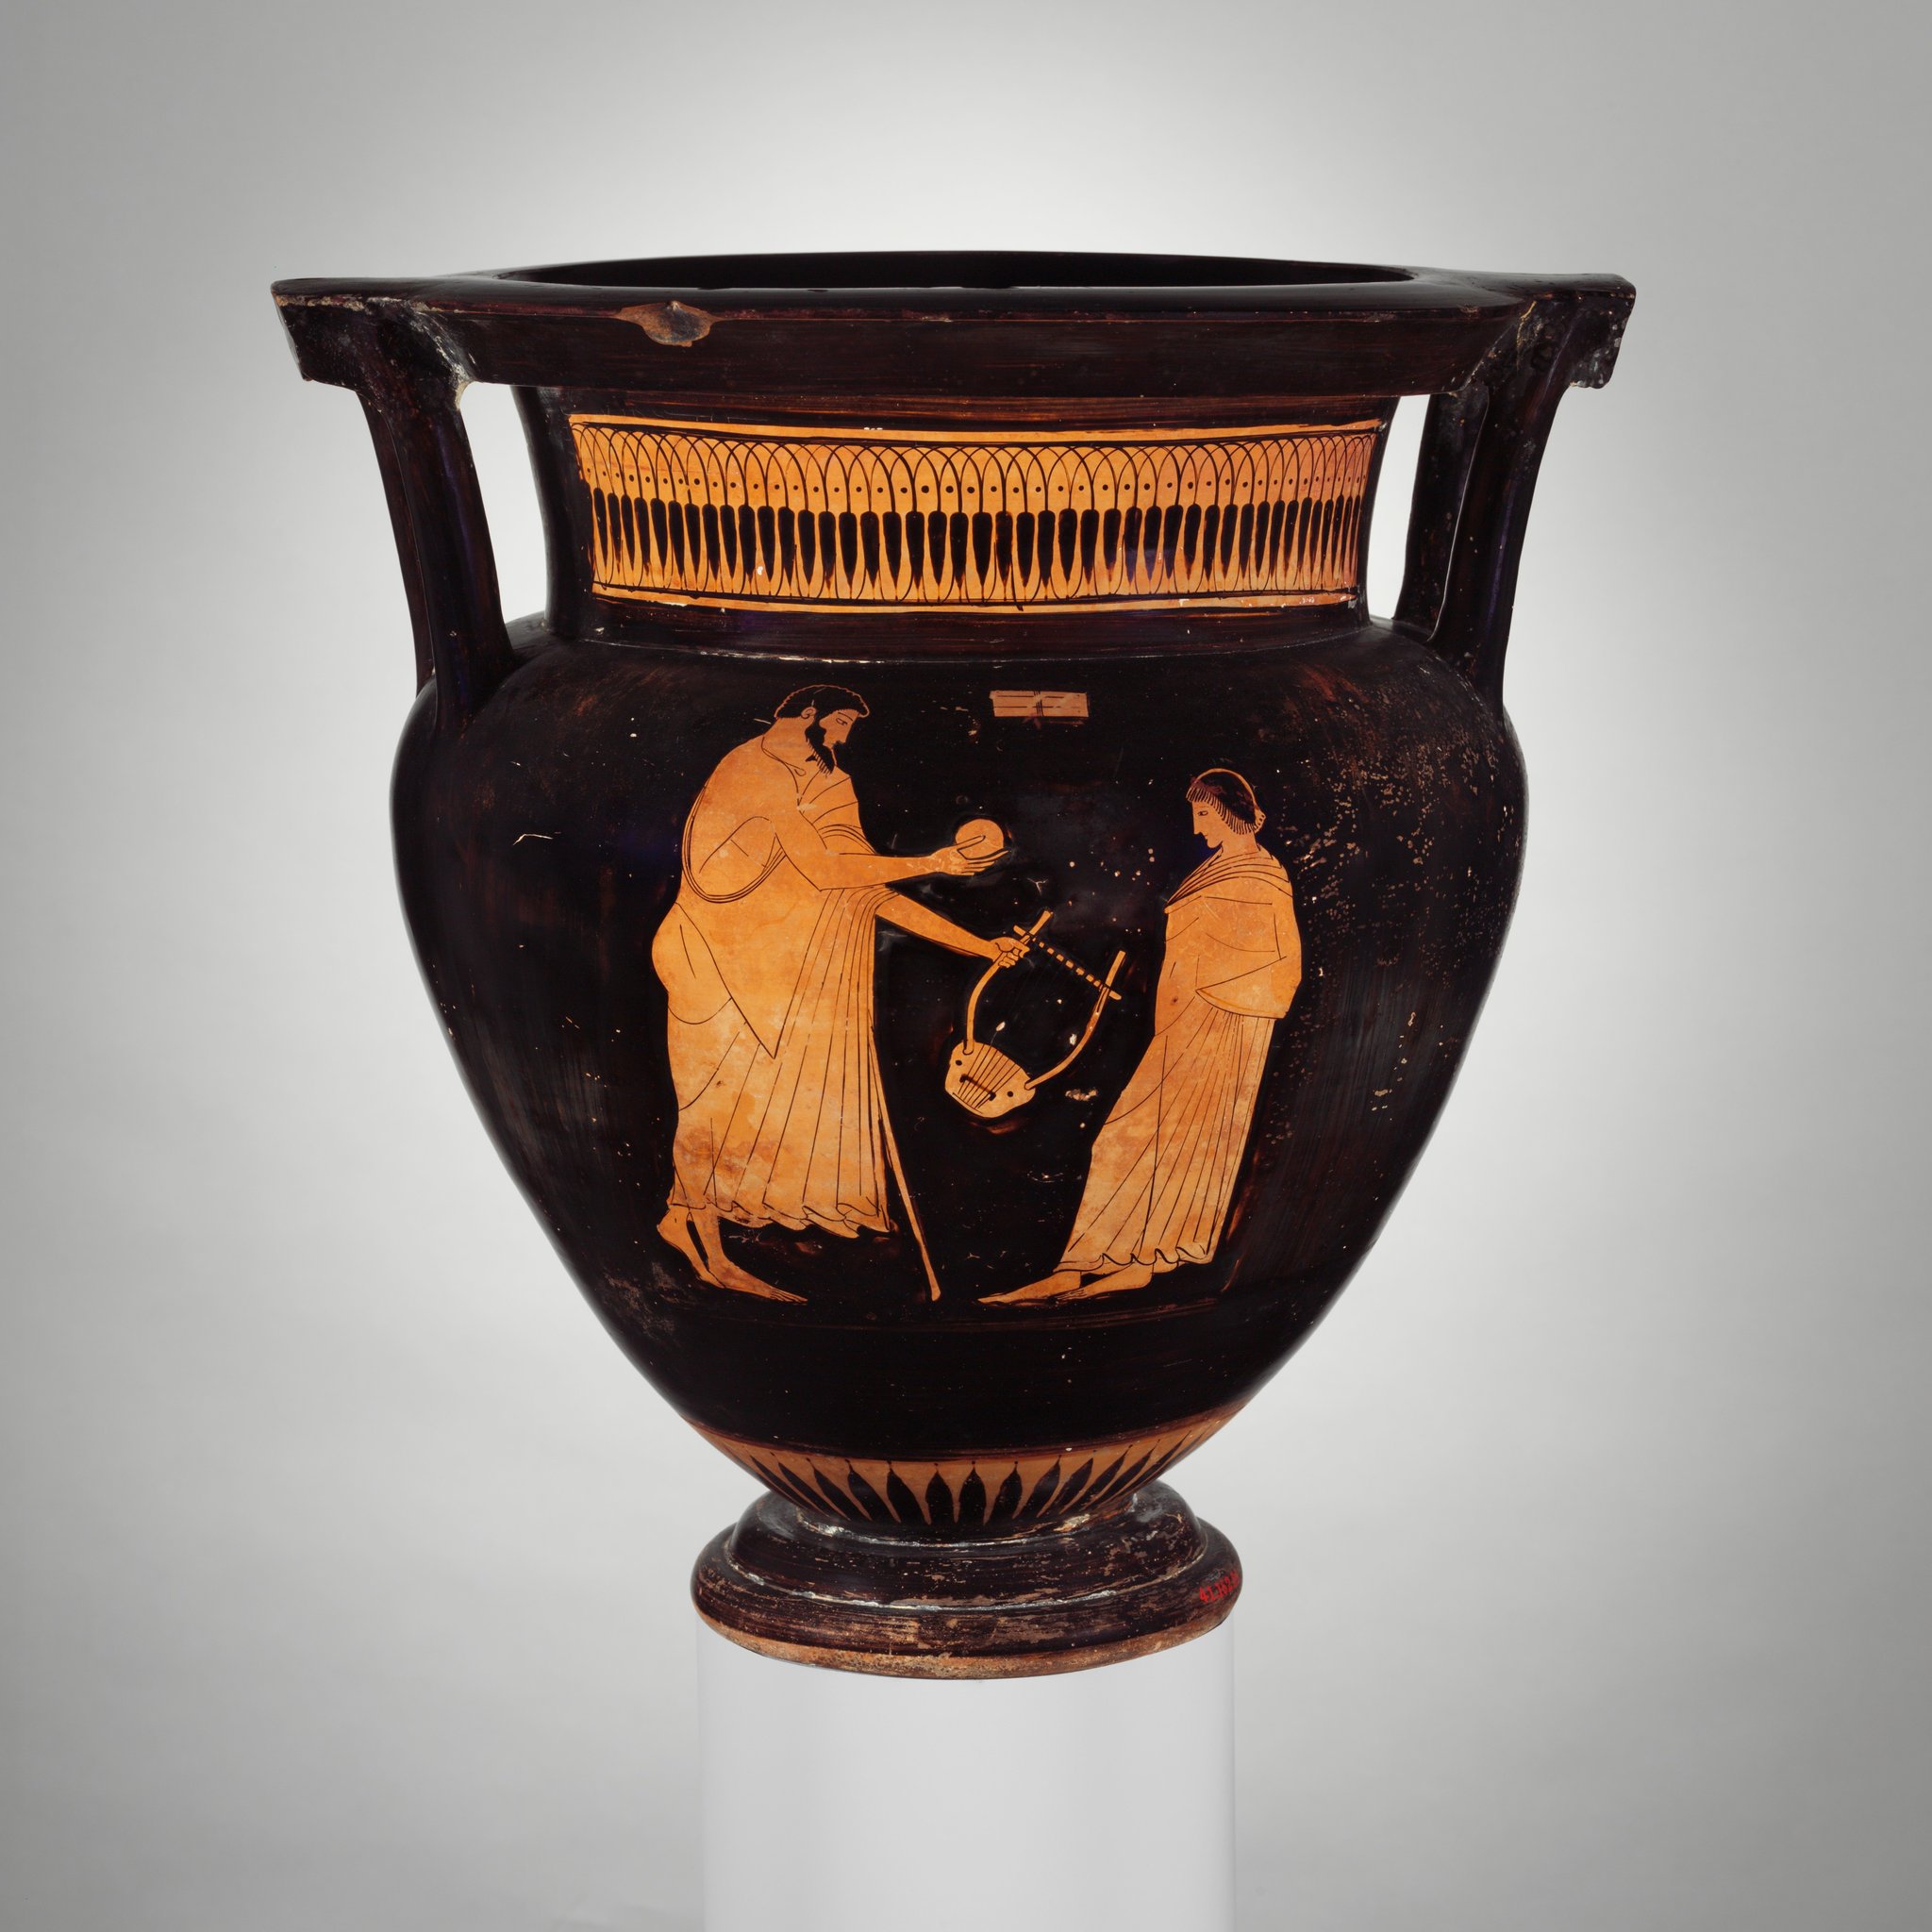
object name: column krater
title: Terracotta column-krater (bowl for mixing wine and water)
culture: greek, attic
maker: pig painter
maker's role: artist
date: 475-465 BCE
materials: terracotta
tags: boys,men,lyres